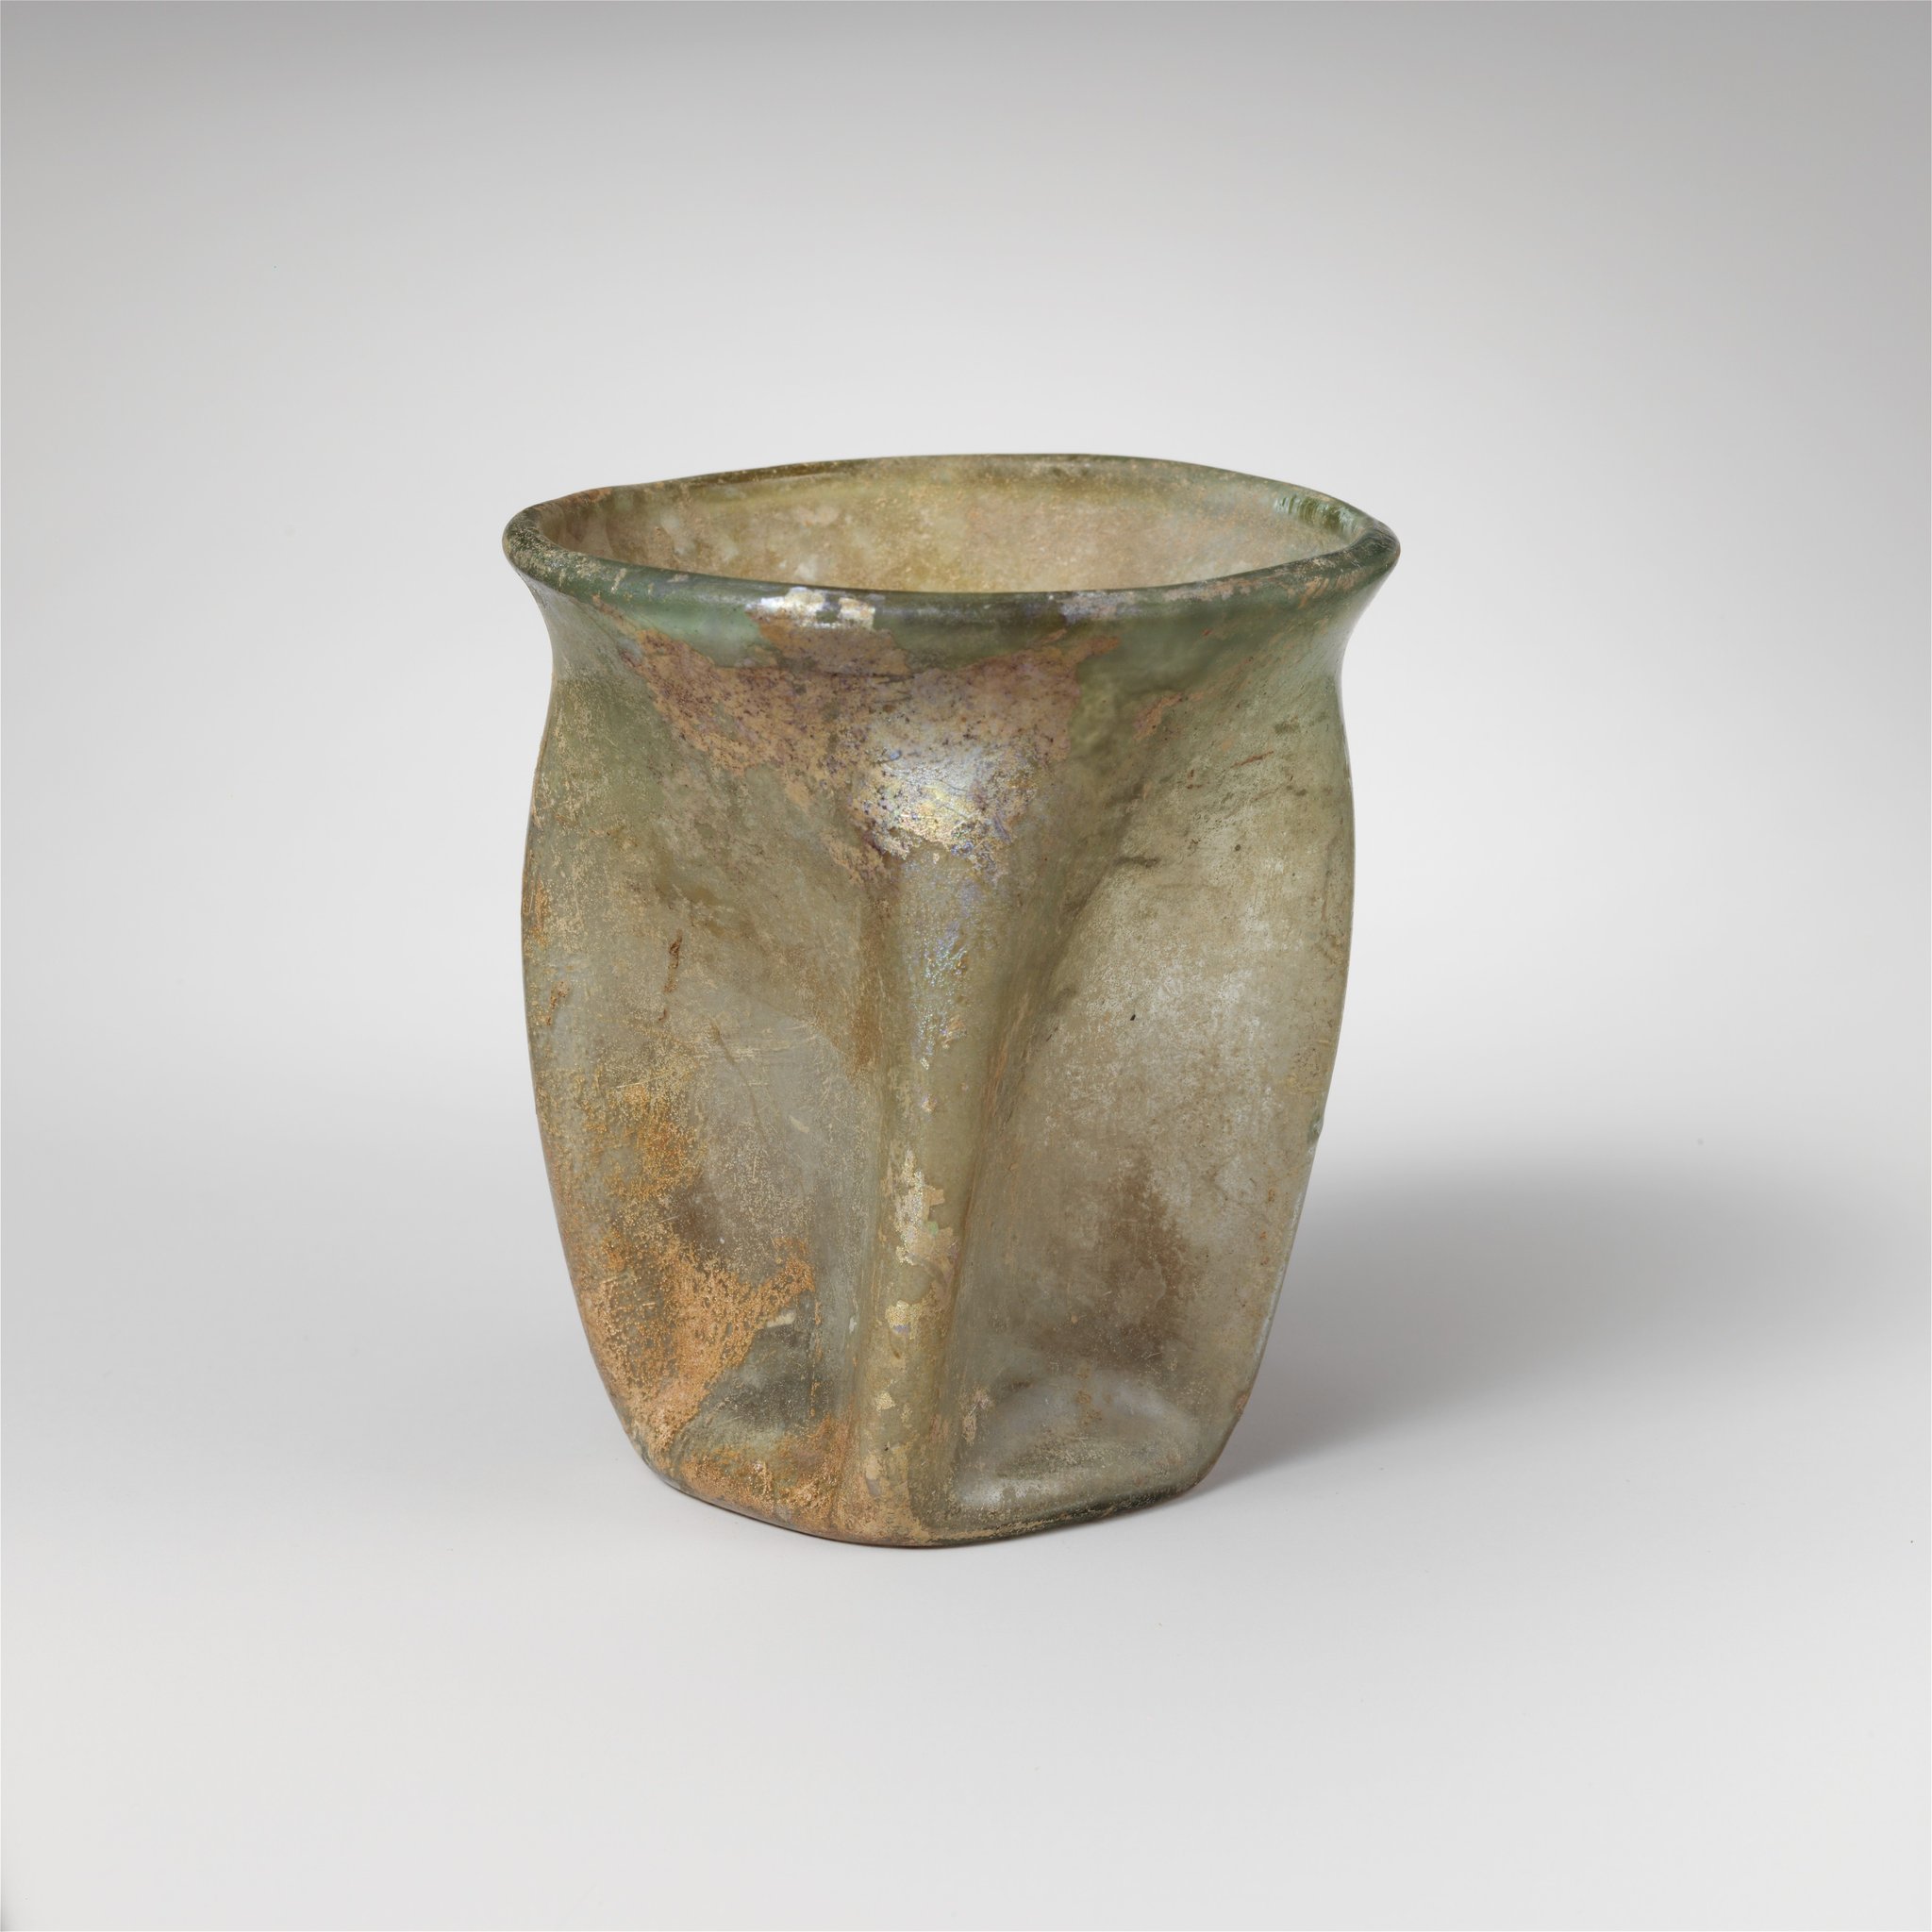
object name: beaker or cup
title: Glass beaker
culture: roman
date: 101-300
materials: glass